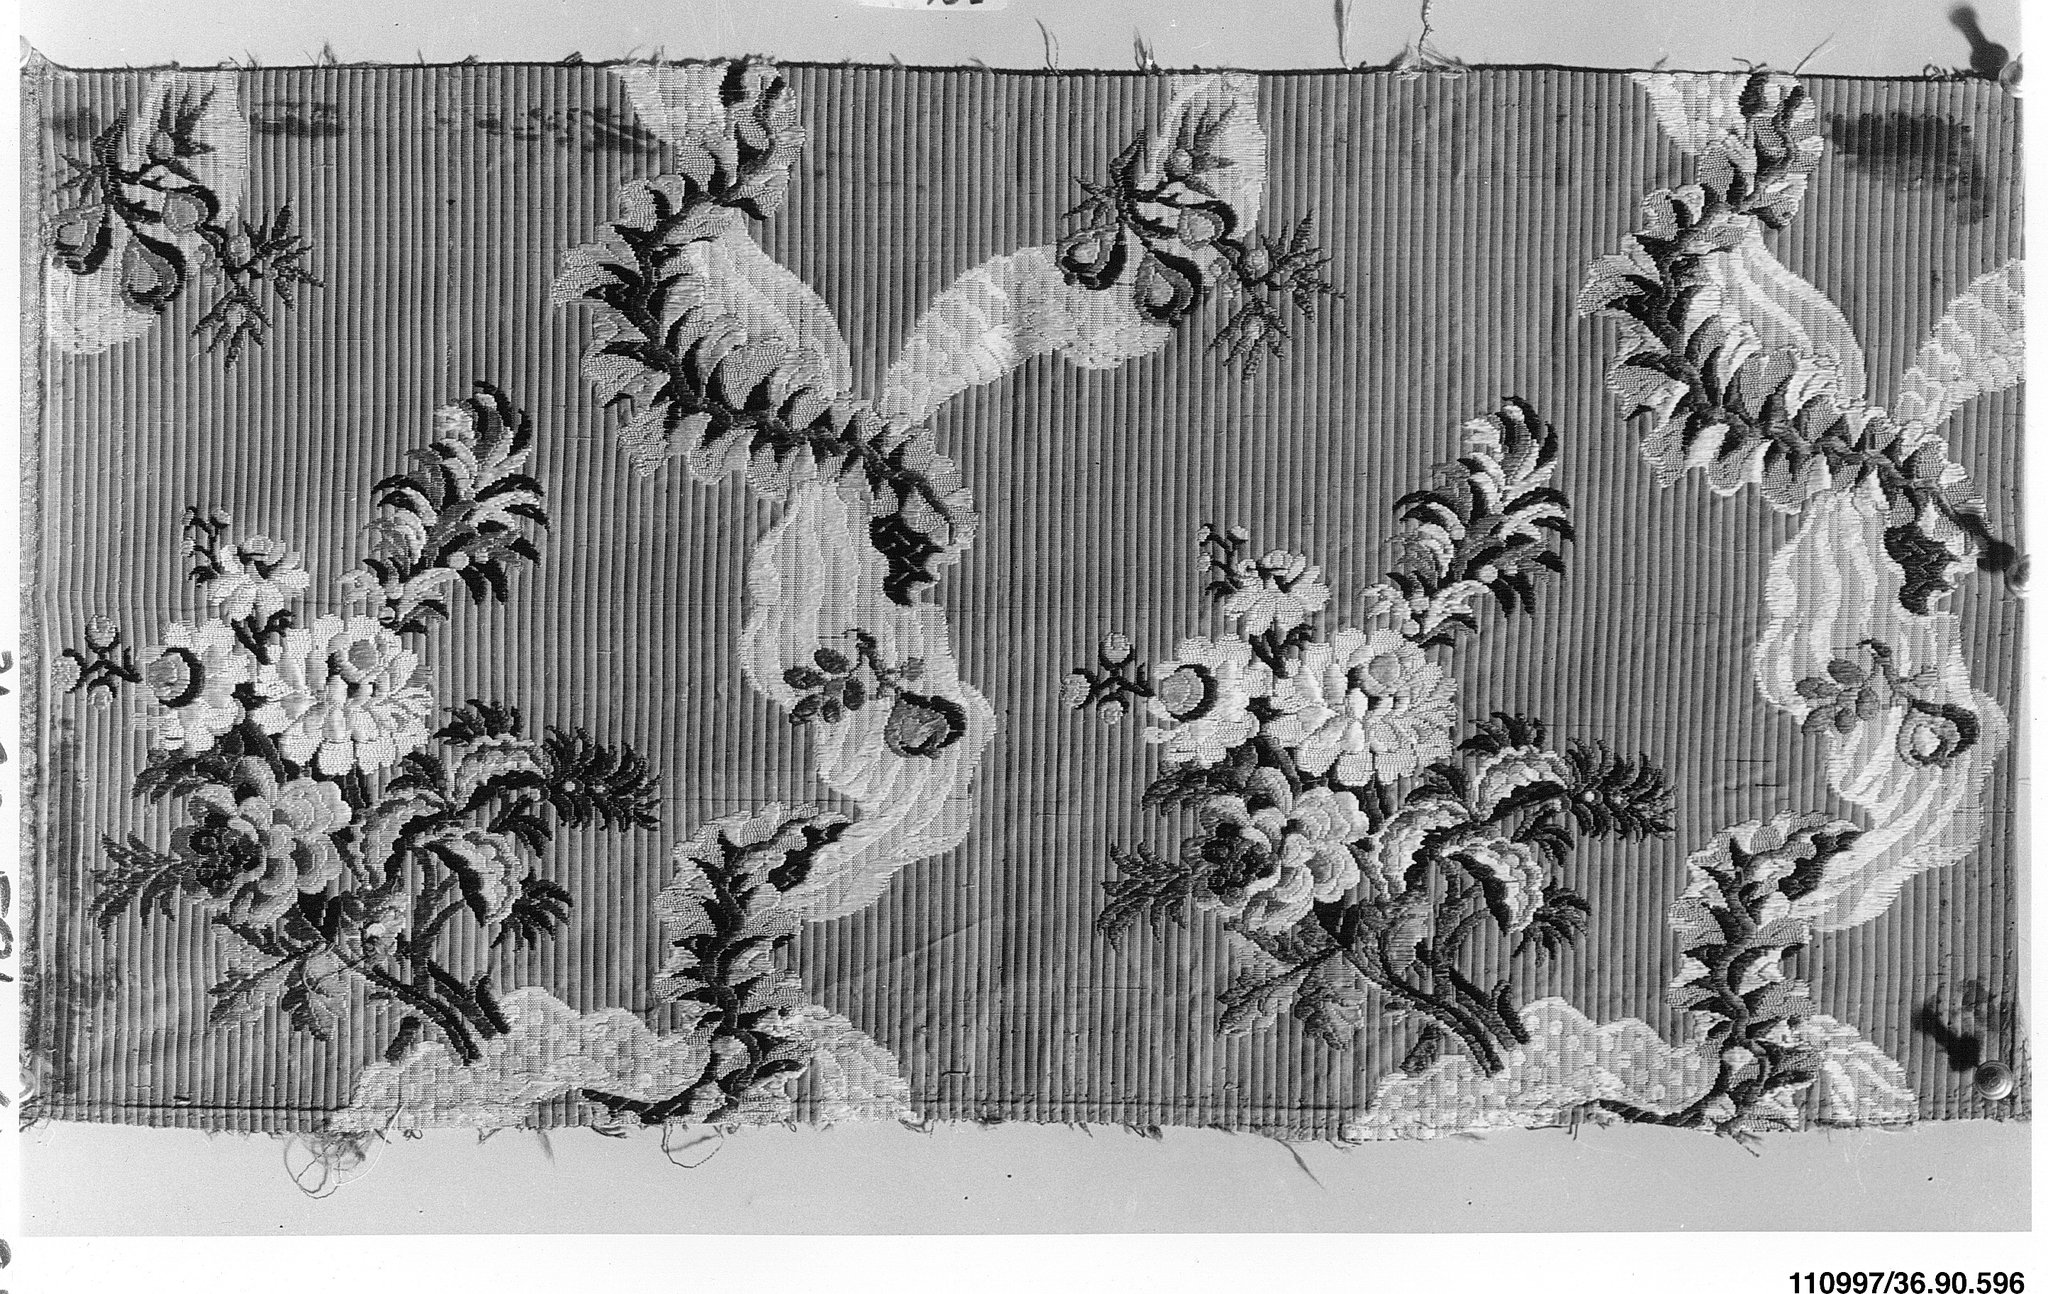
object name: piece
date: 1734-1766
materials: silk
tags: flowers,leaves